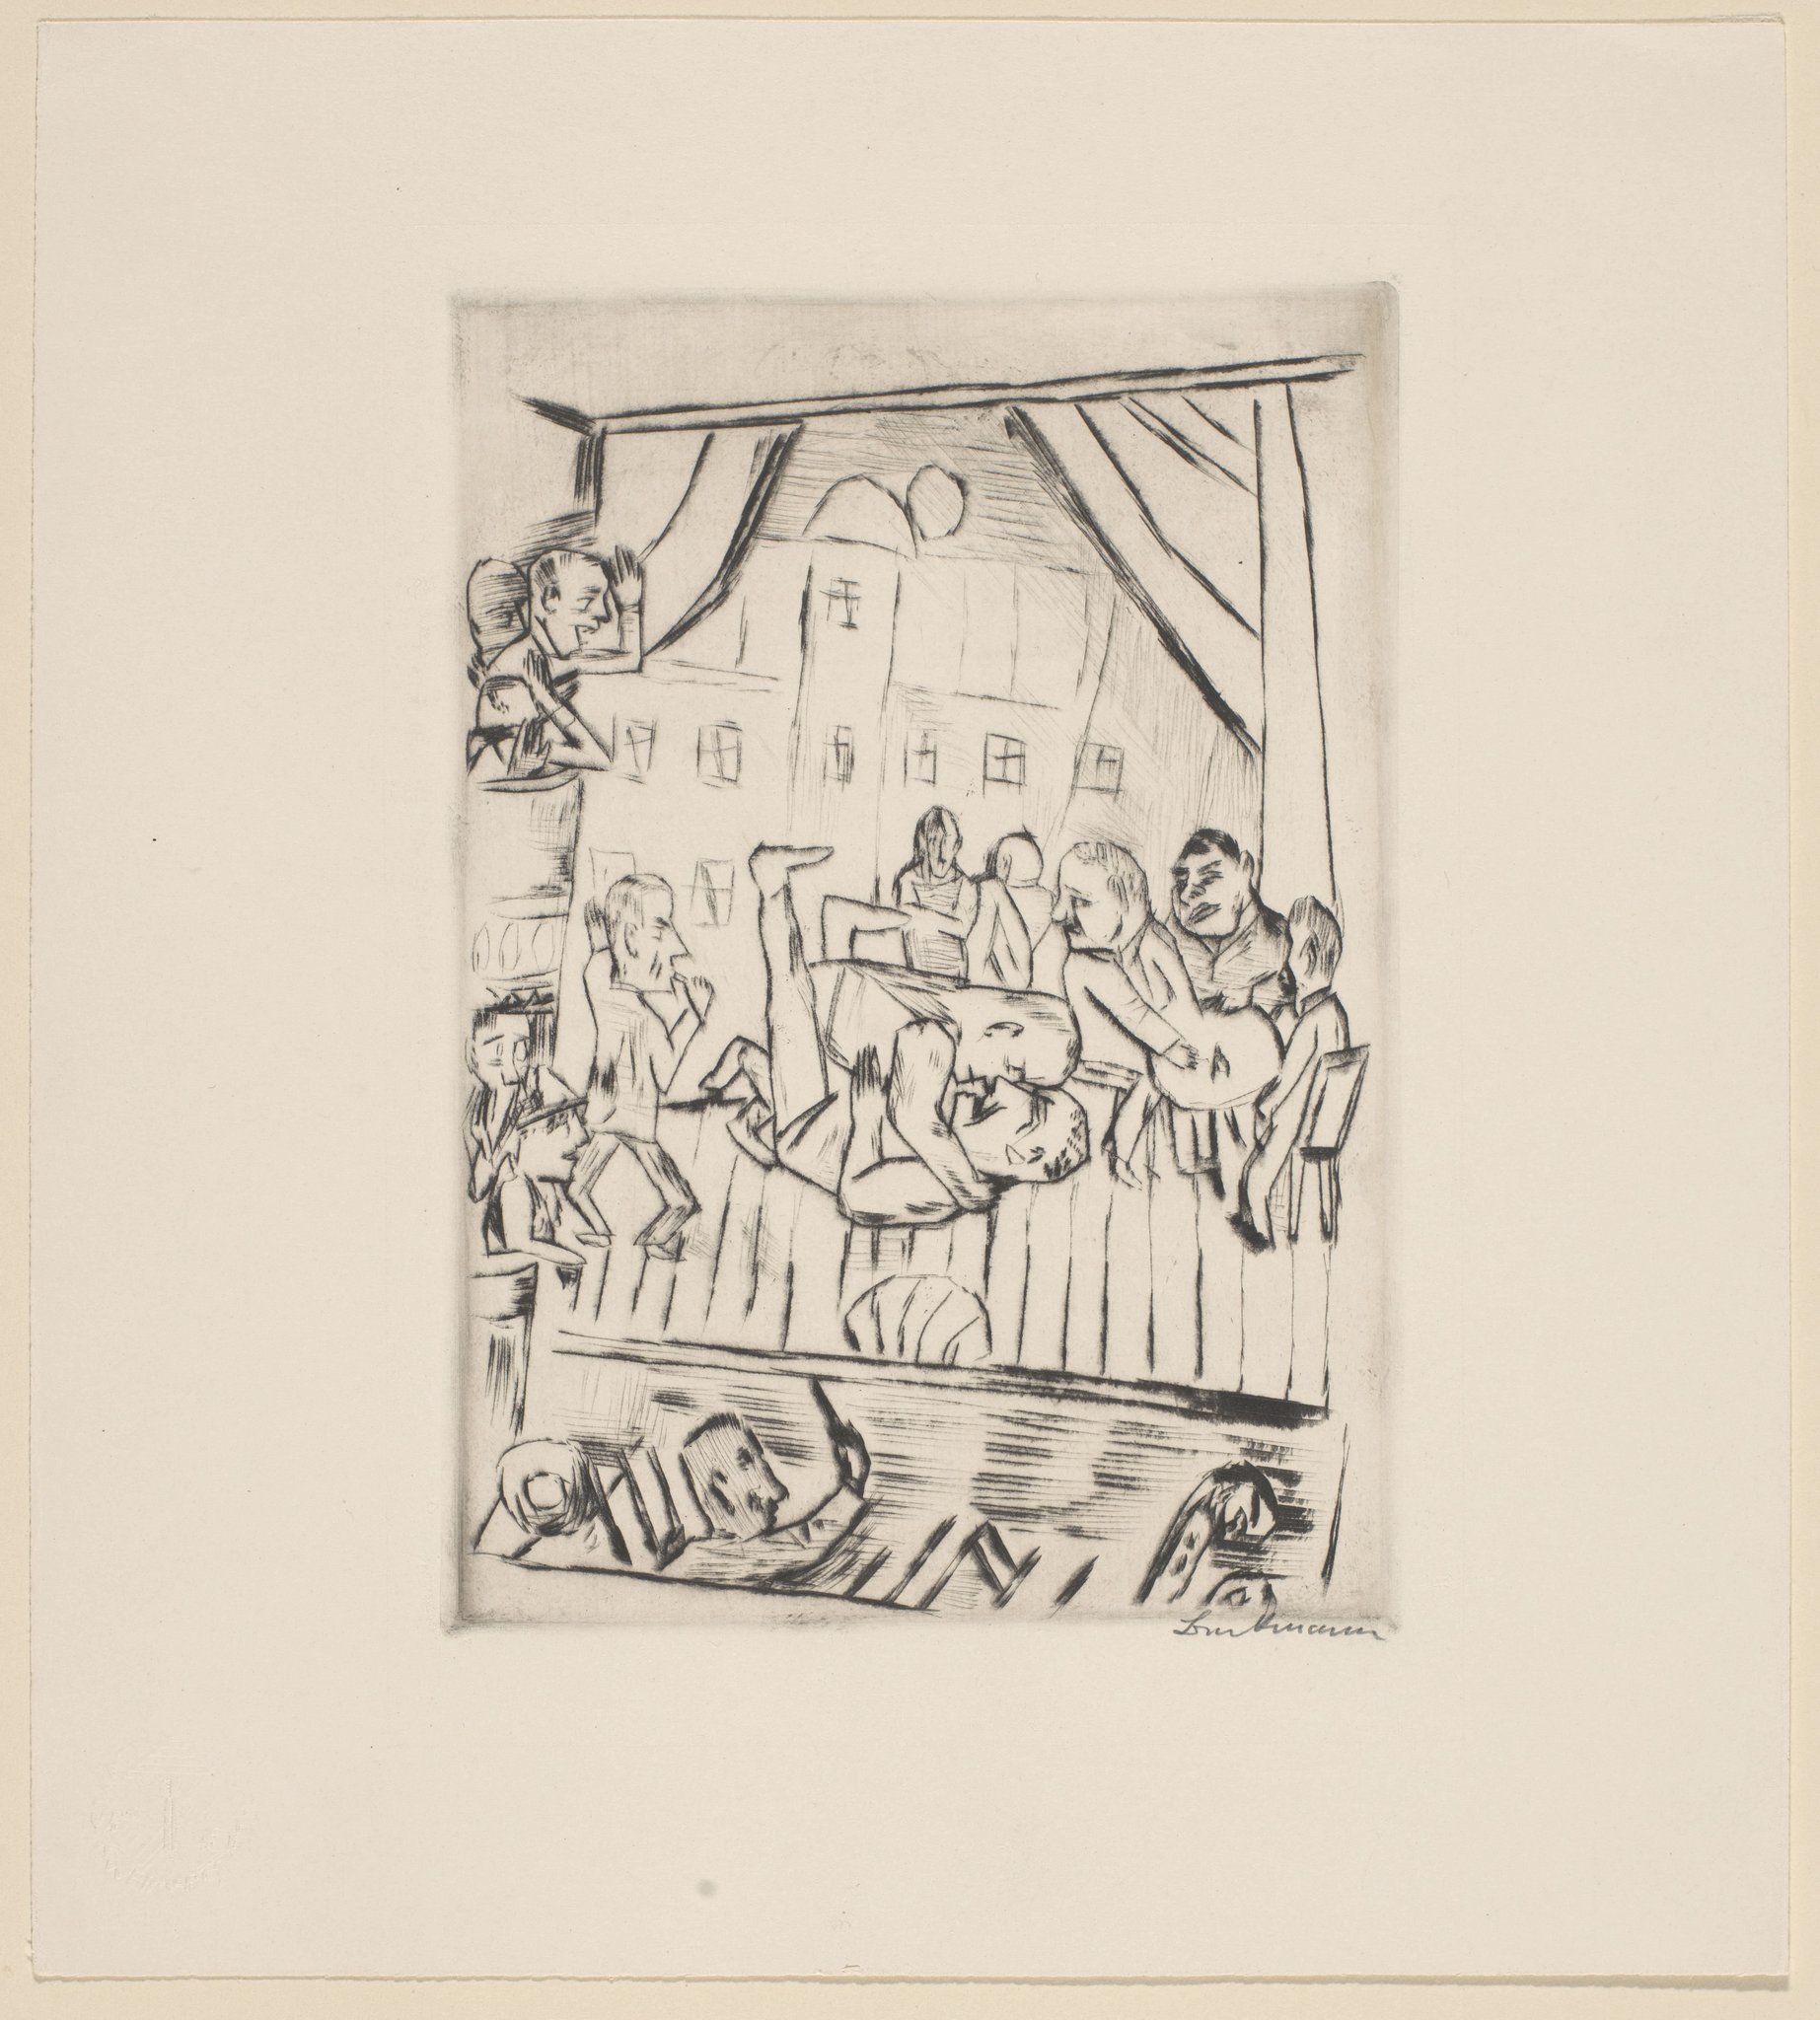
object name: print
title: Die Ringer (The Wrestlers)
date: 1921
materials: paper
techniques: drypoint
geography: weimar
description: Two men are wrestling as they roll across the floor. They are not in a ring, but on the stage of a theatre, along with a referee and three men at a café table. People watch gleefully from their theatre boxes. The conductor in the orchestra pit provides the musical accompaniment. In this print Beckmann conveys his rather gloomy, melancholic vision of German society.